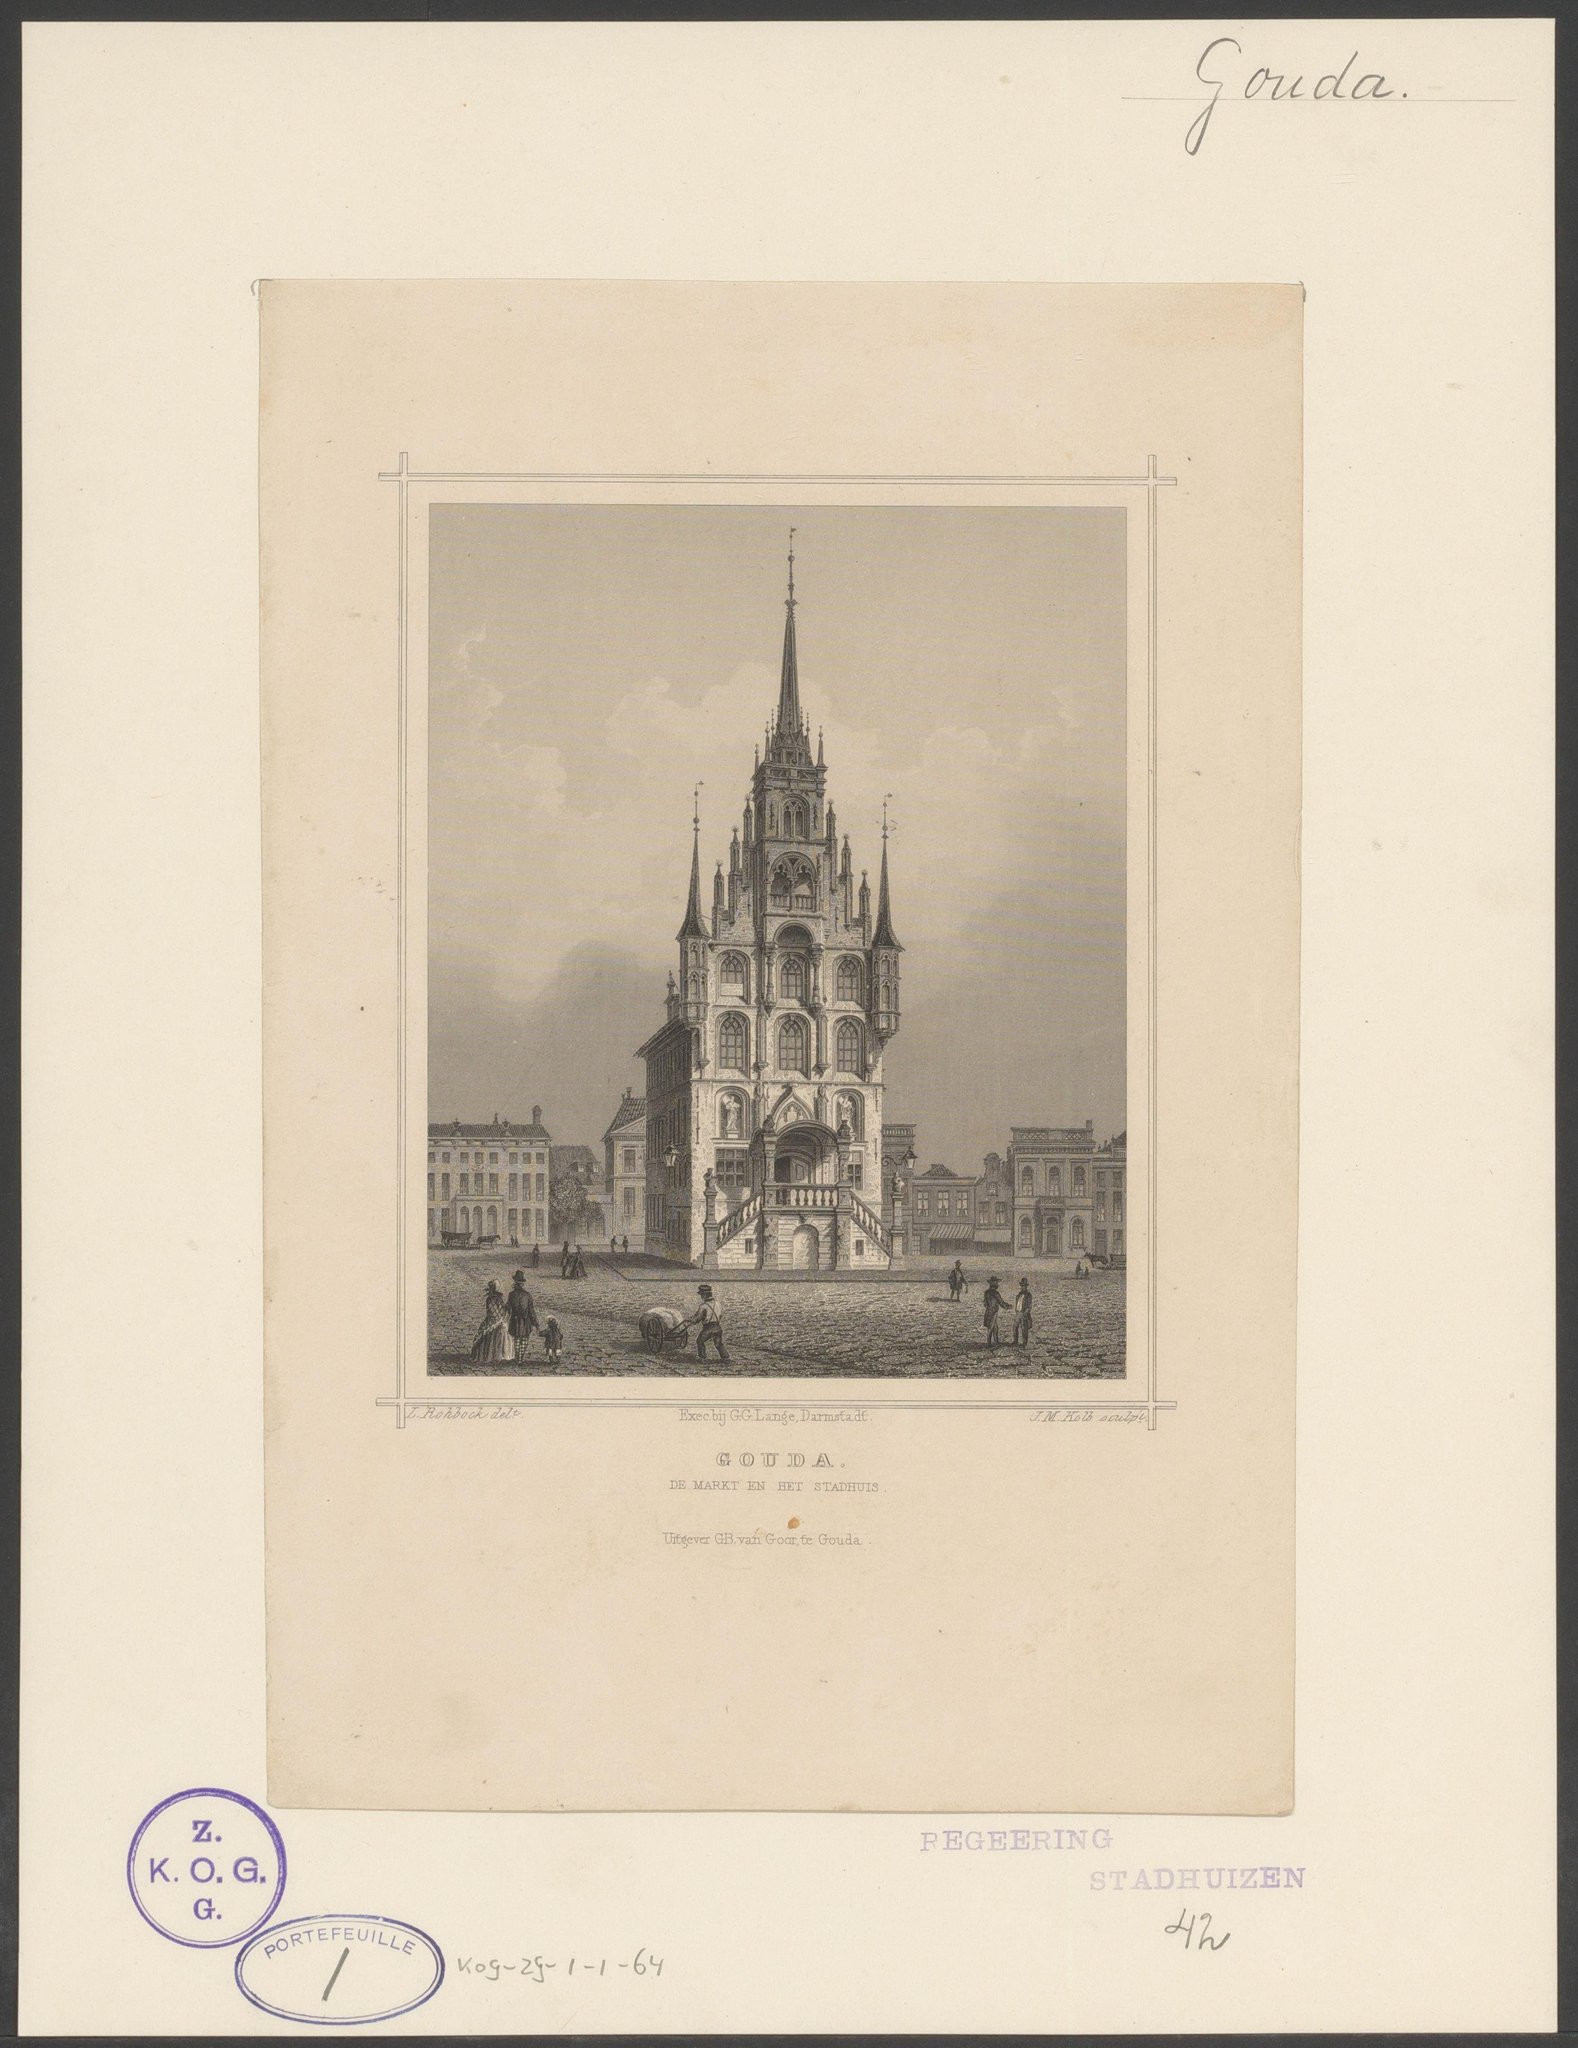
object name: print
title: Gouda. De Markt en het Stadhuis.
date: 1855-1857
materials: paper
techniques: engraving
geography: darmstadt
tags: townhall, market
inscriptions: collector's mark, collector's mark: Lugt 1641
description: Prent uit: Terwen, J.L. Het koningrijk der Nederlanden (...). 2 dln. Gouda: G.B. van Goor, 1857. Dezelfde prent, met een ander onderschrift, komt ook voor in: Der Rhein und die Rheinlande in malerischen Original-ansichten. 3 dln. Darmstadt: G.G. Lange, 1863.